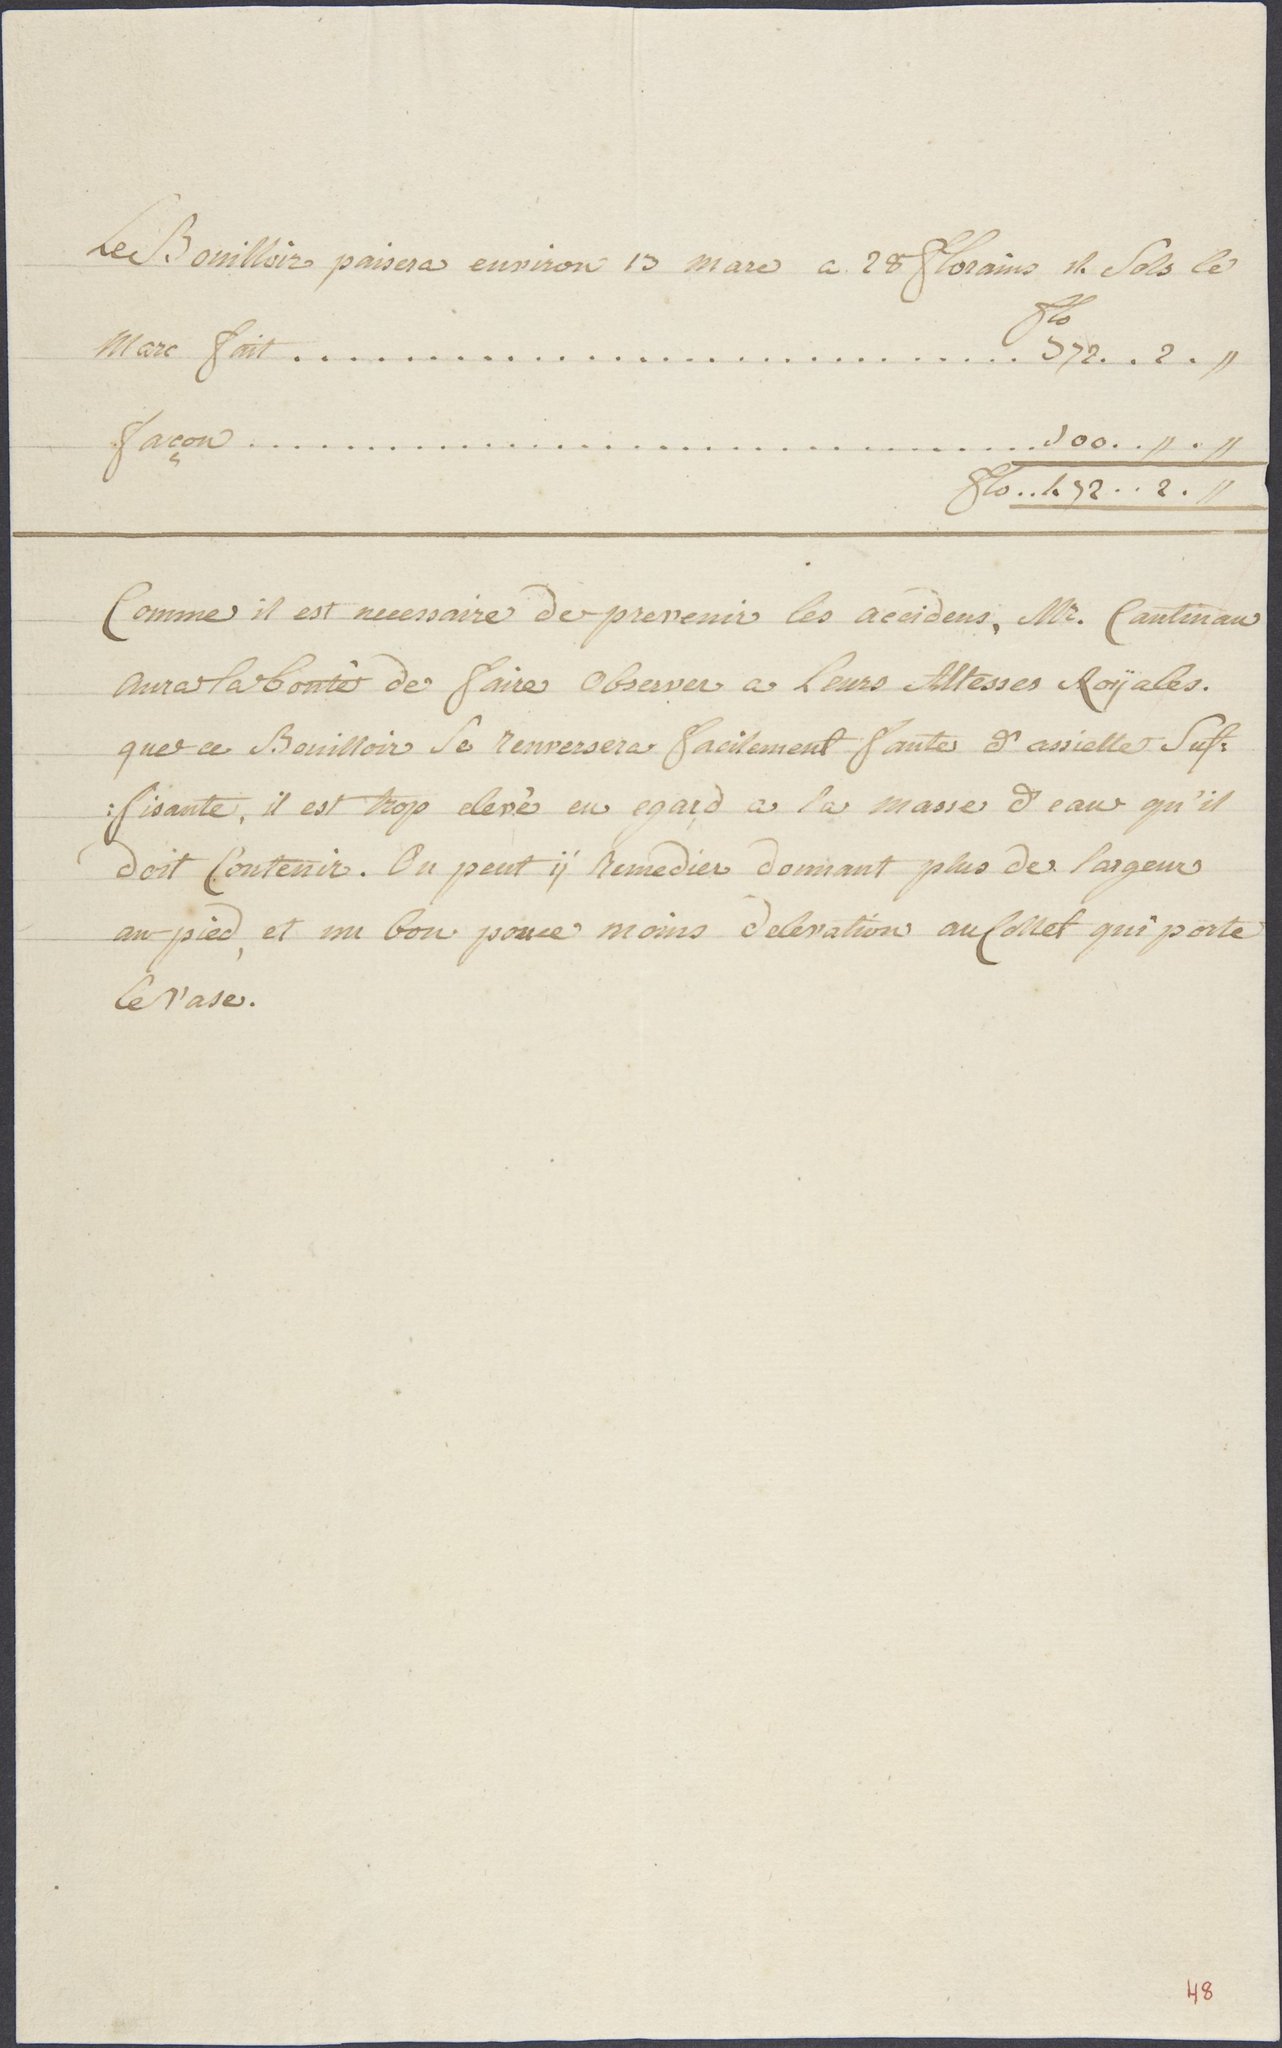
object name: document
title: Estimate for repair work and explanatory note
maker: anonymous, french, 18th century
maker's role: artist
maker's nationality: french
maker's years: 1700-1800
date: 1701-1800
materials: ink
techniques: pen